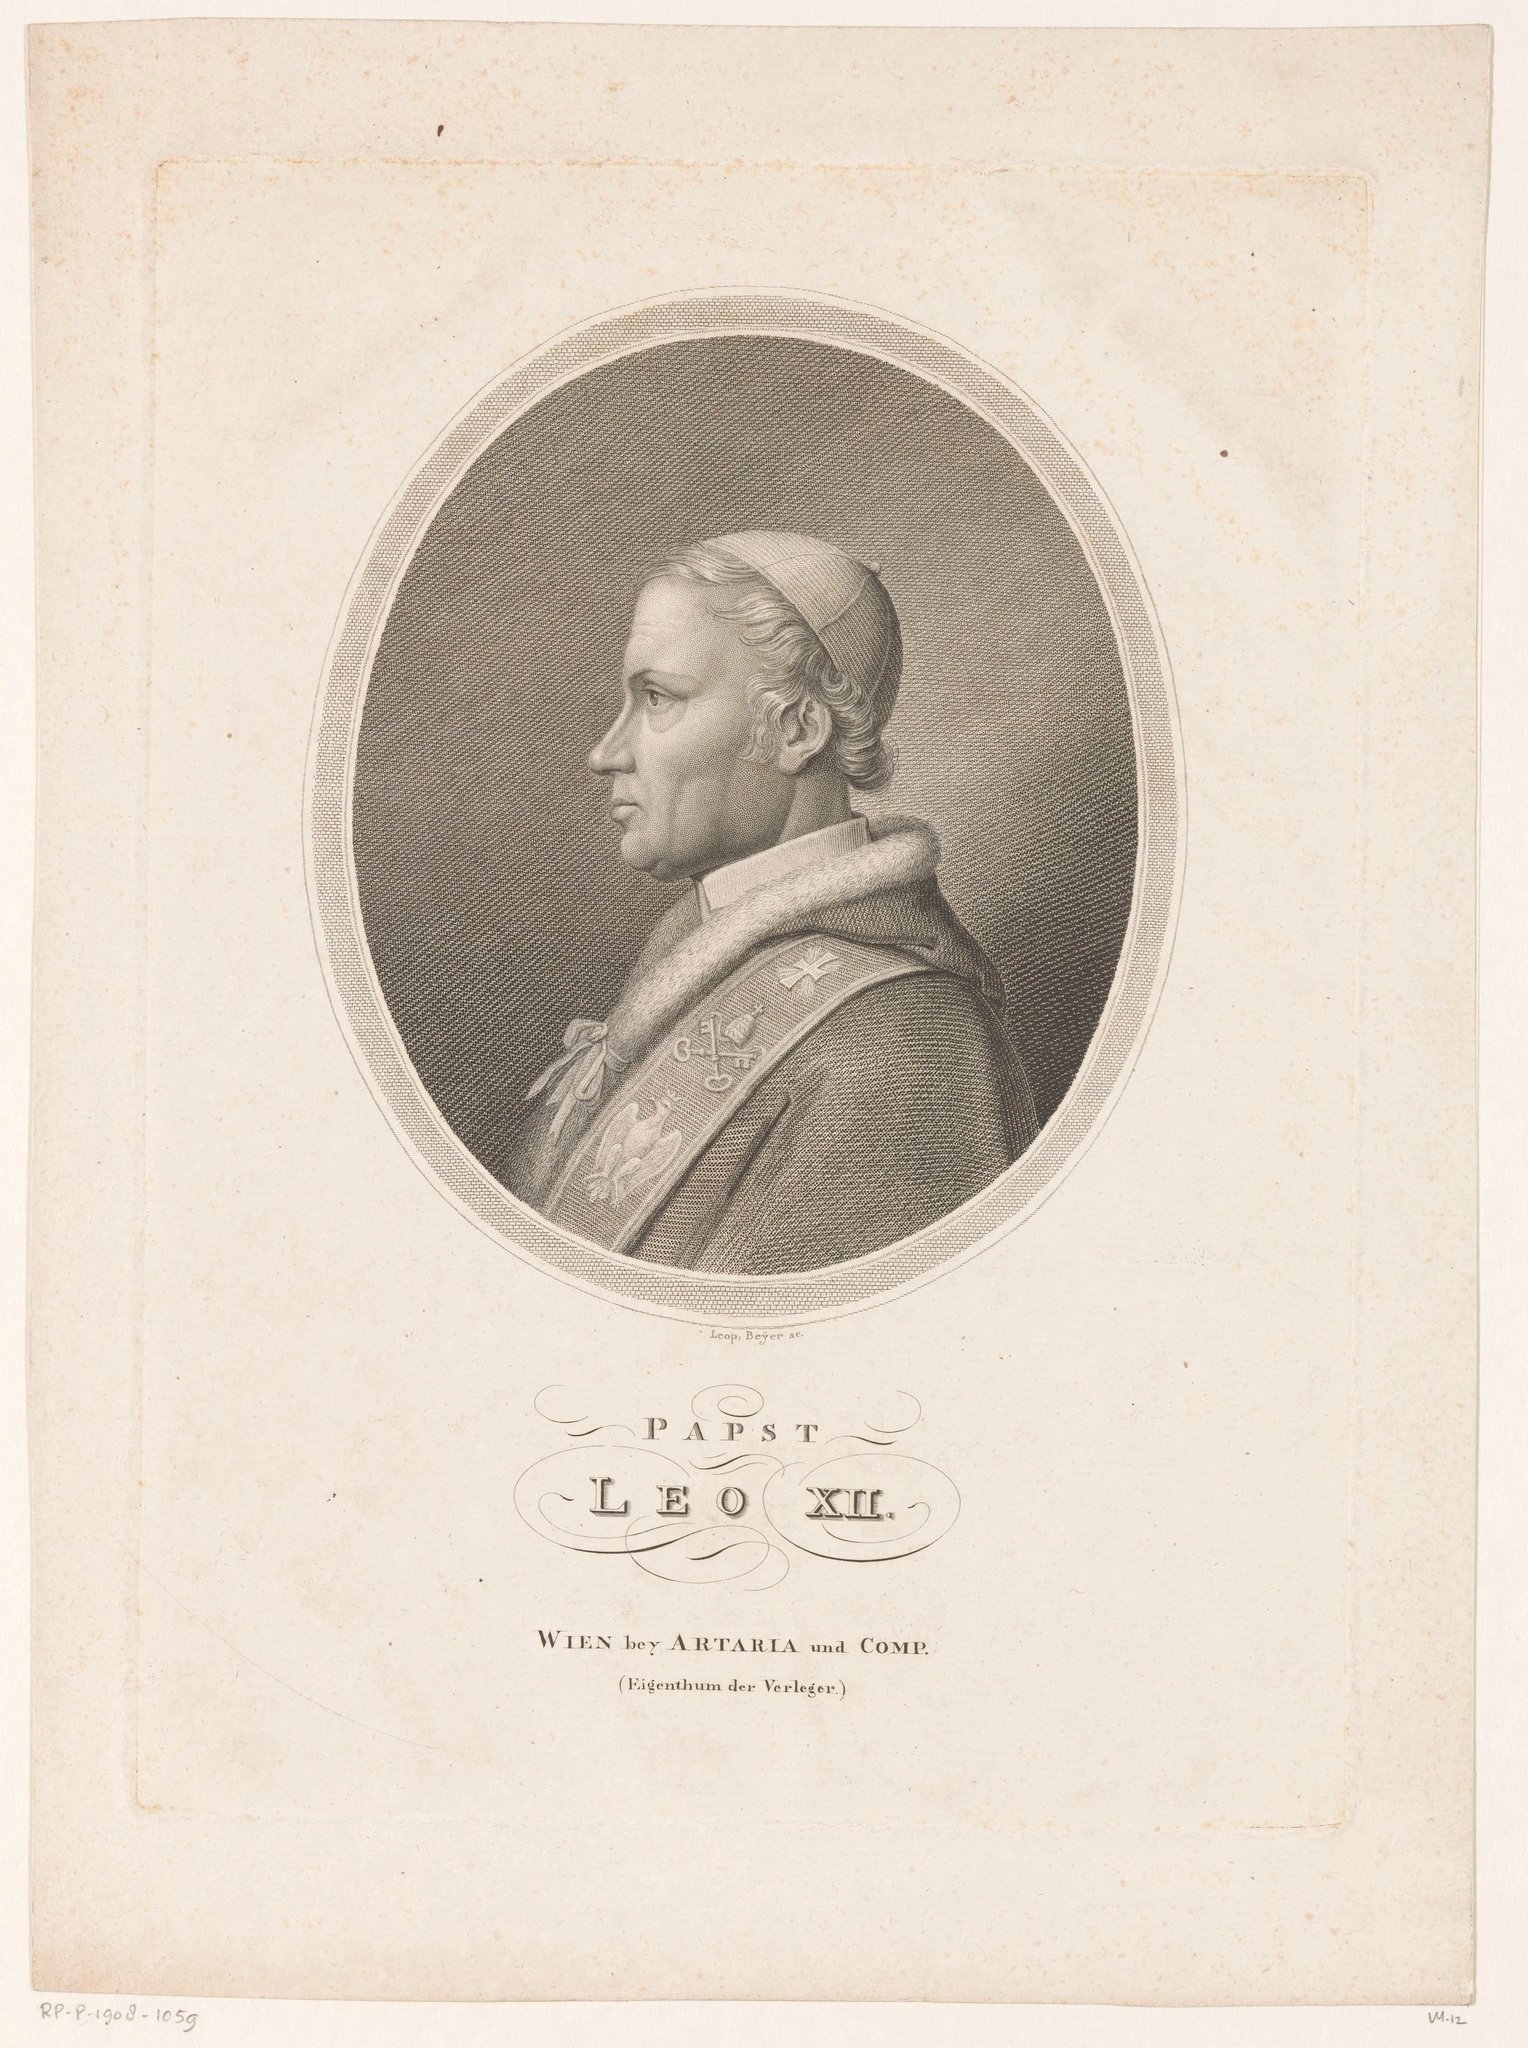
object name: print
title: Portret van paus Leo XII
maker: leopold beyer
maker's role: print maker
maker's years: 1789-1877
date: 1823-1877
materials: paper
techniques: engraving, etching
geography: vienna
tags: rome, historical persons, pope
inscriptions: collector's mark: Lugt 2228